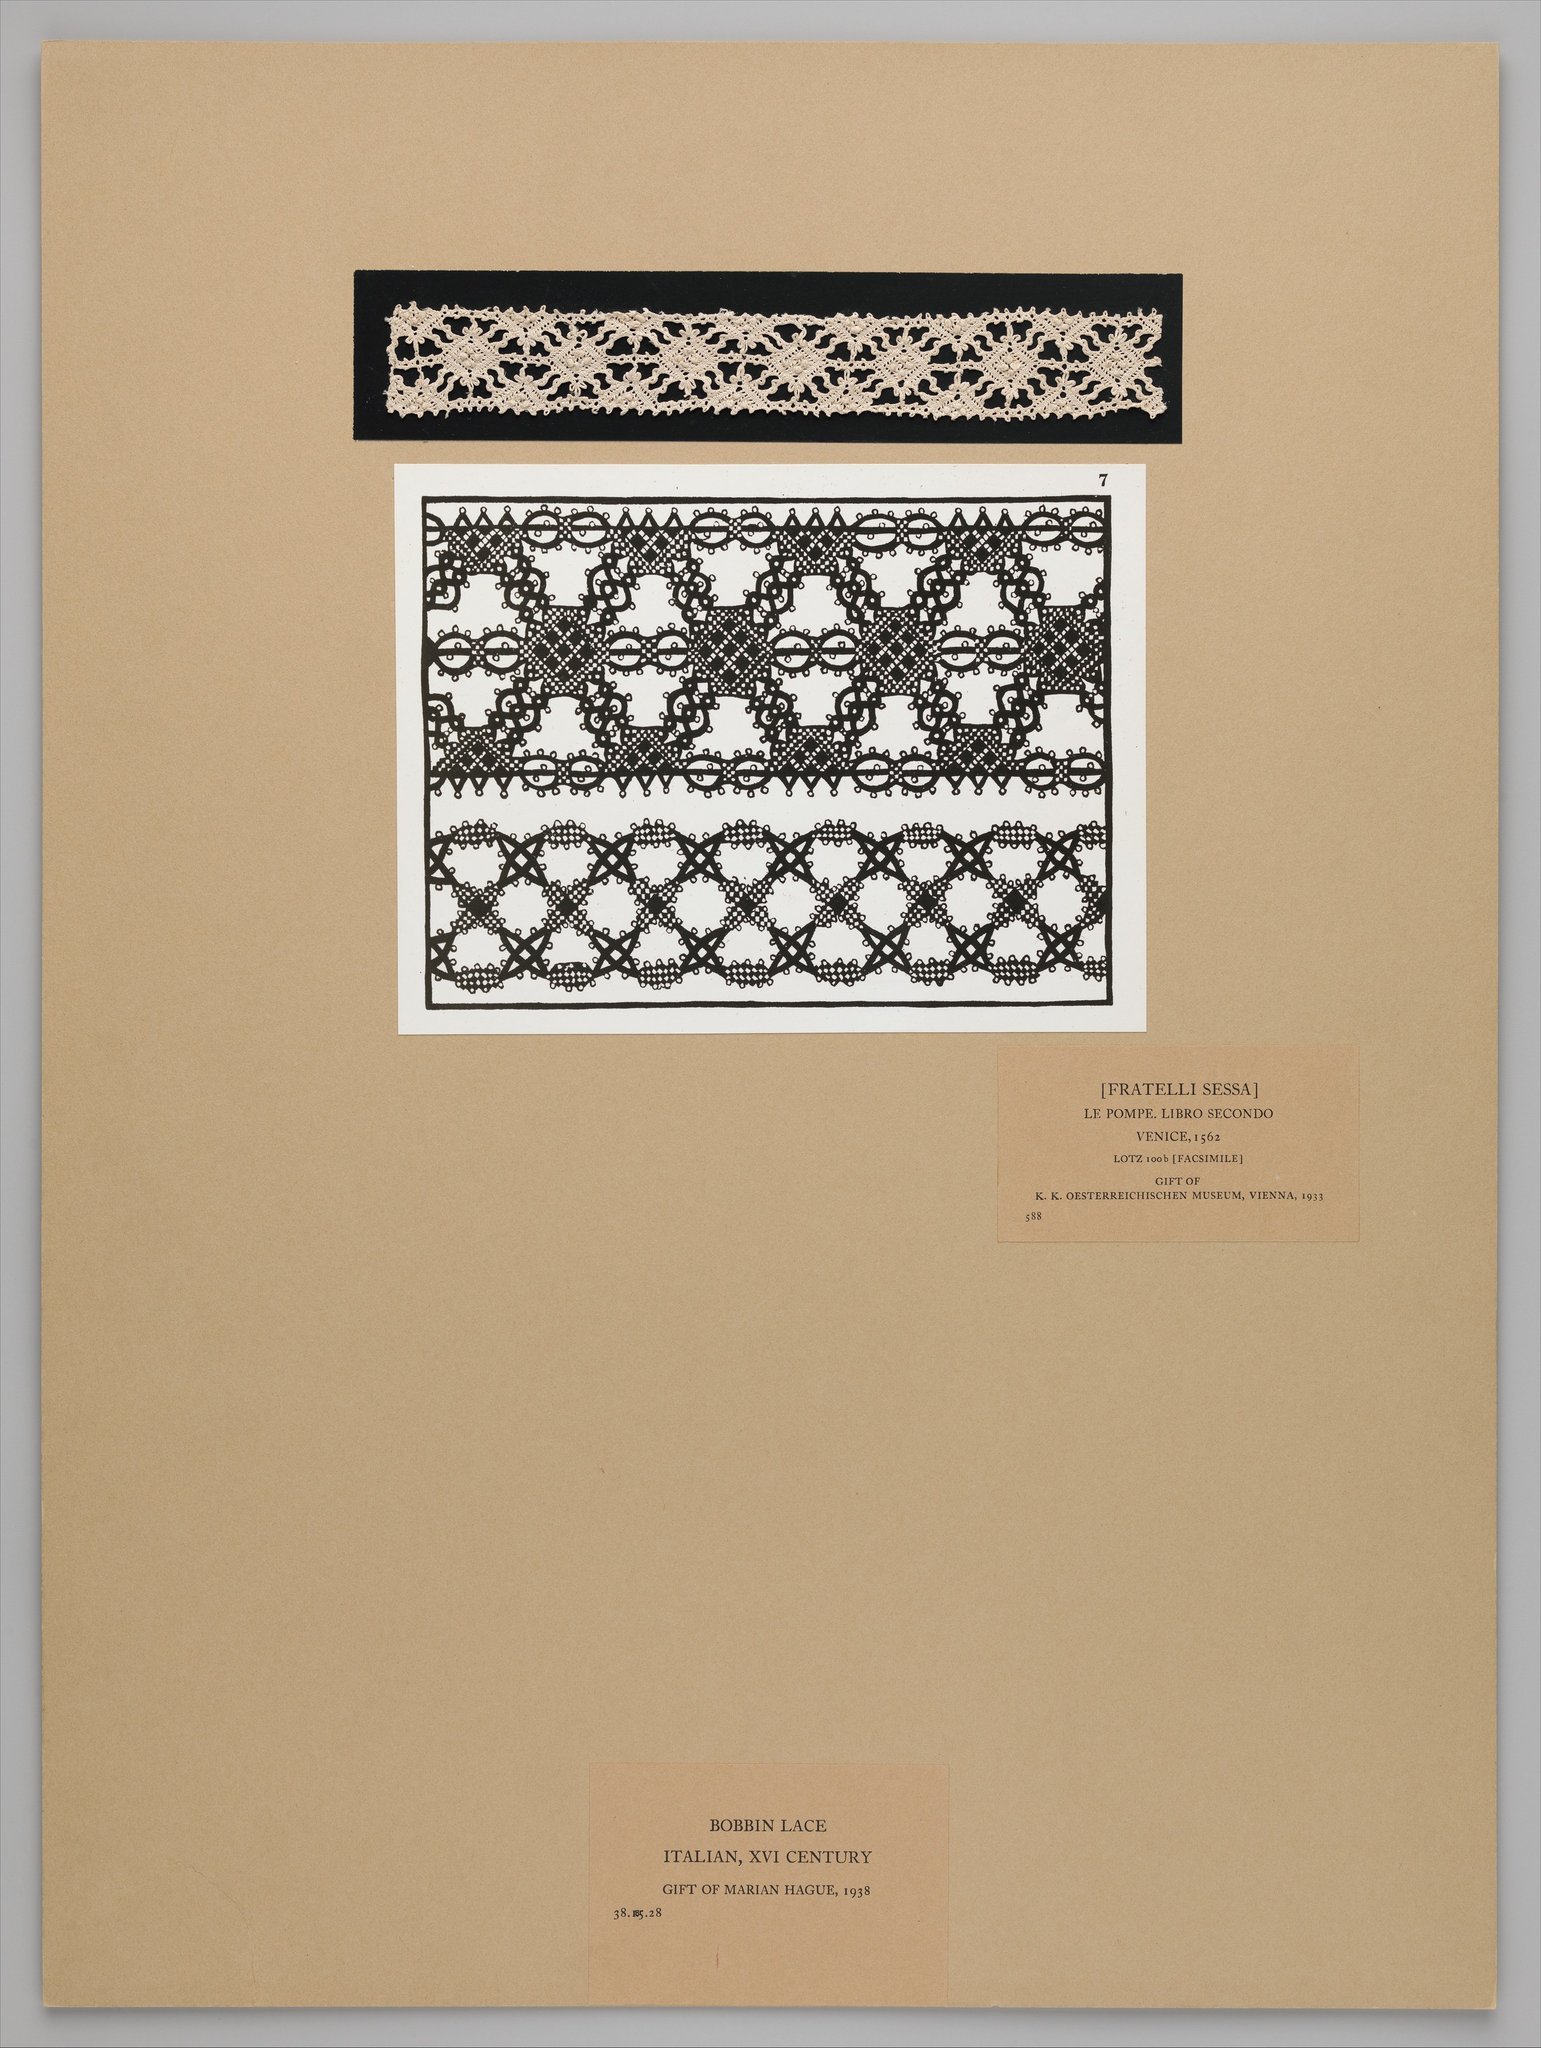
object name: lace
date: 1501-1600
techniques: lace